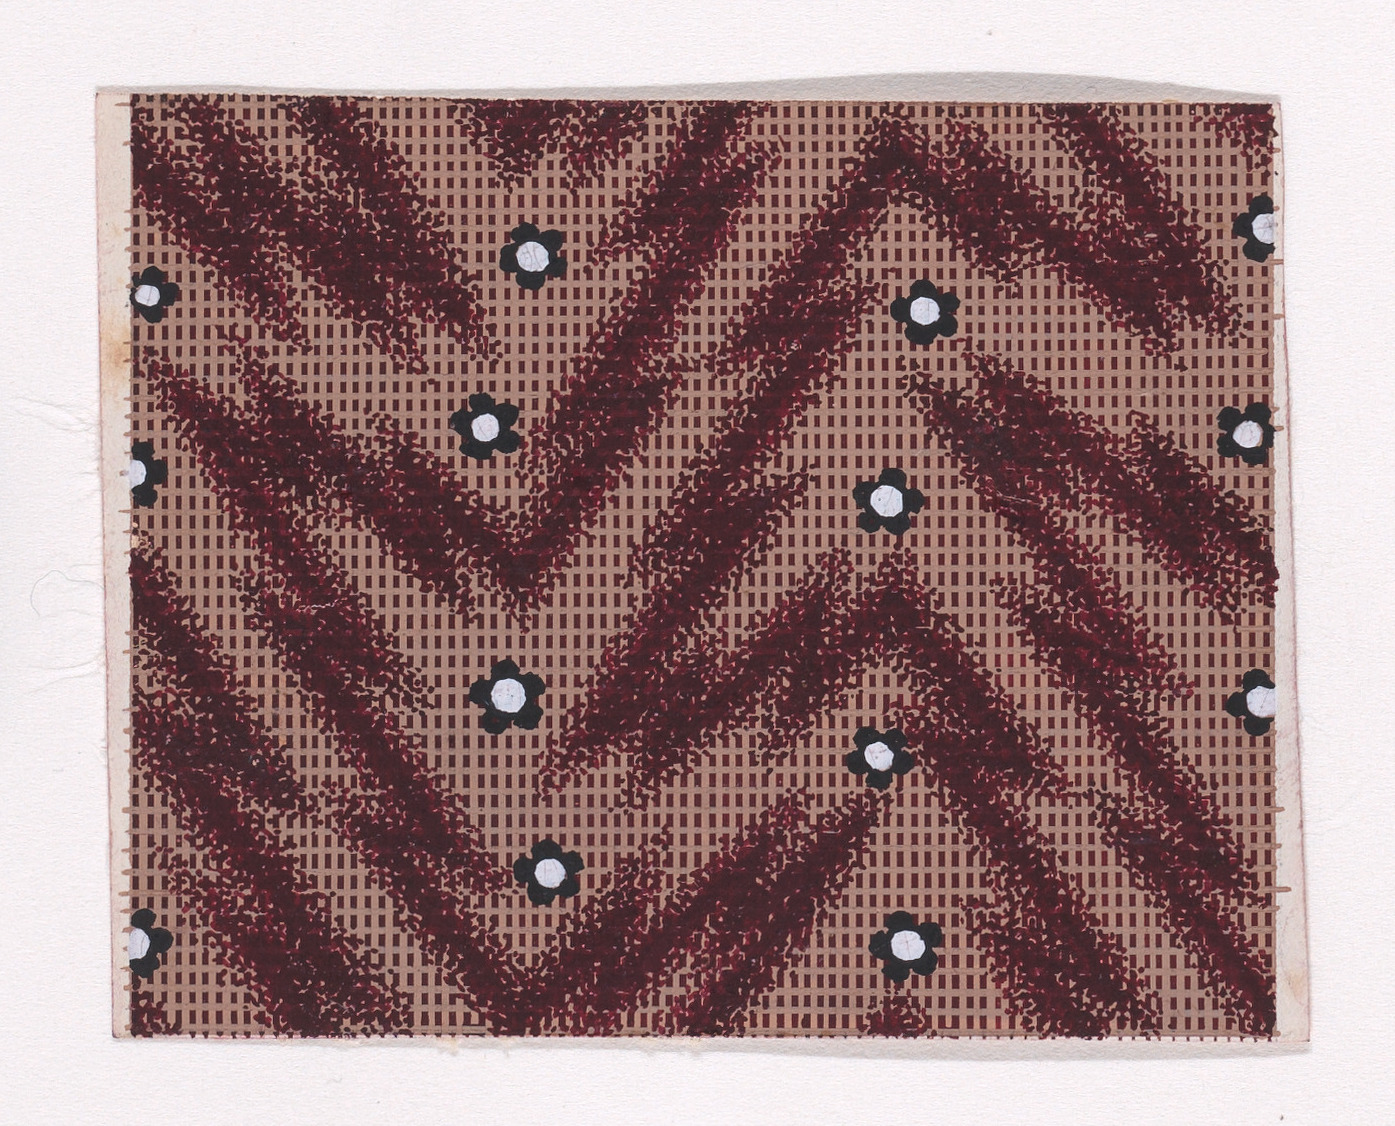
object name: drawing ornament architecture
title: Textile Design with Rosettes and Pearls over a Checked Background with Zig-Zagging Lines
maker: anonymous, alsatian, 19th century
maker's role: artist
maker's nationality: alsatian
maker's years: 1800-1900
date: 1840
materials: gouache